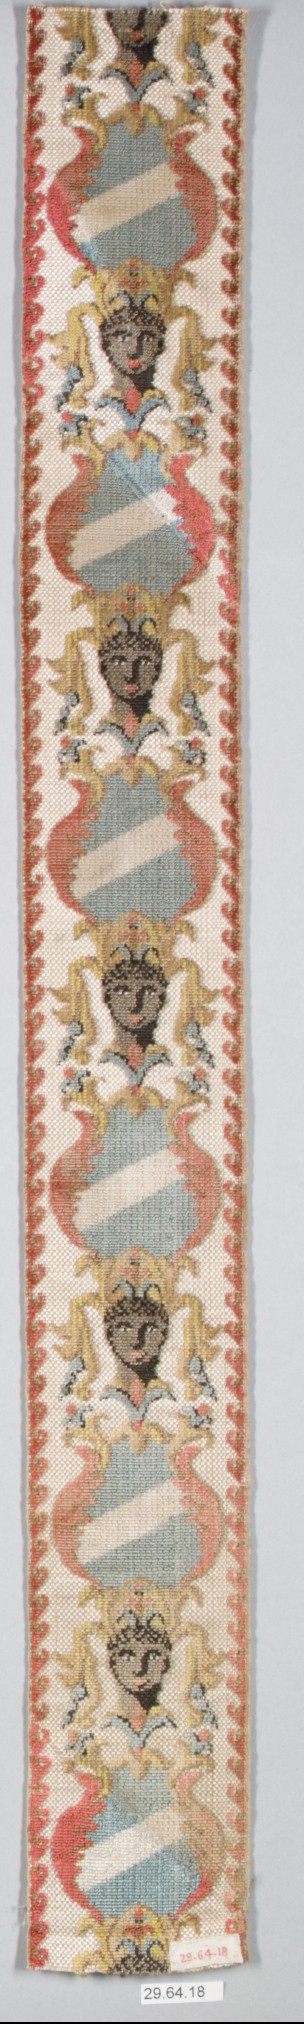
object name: galloon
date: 1701-1900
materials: silk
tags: faces